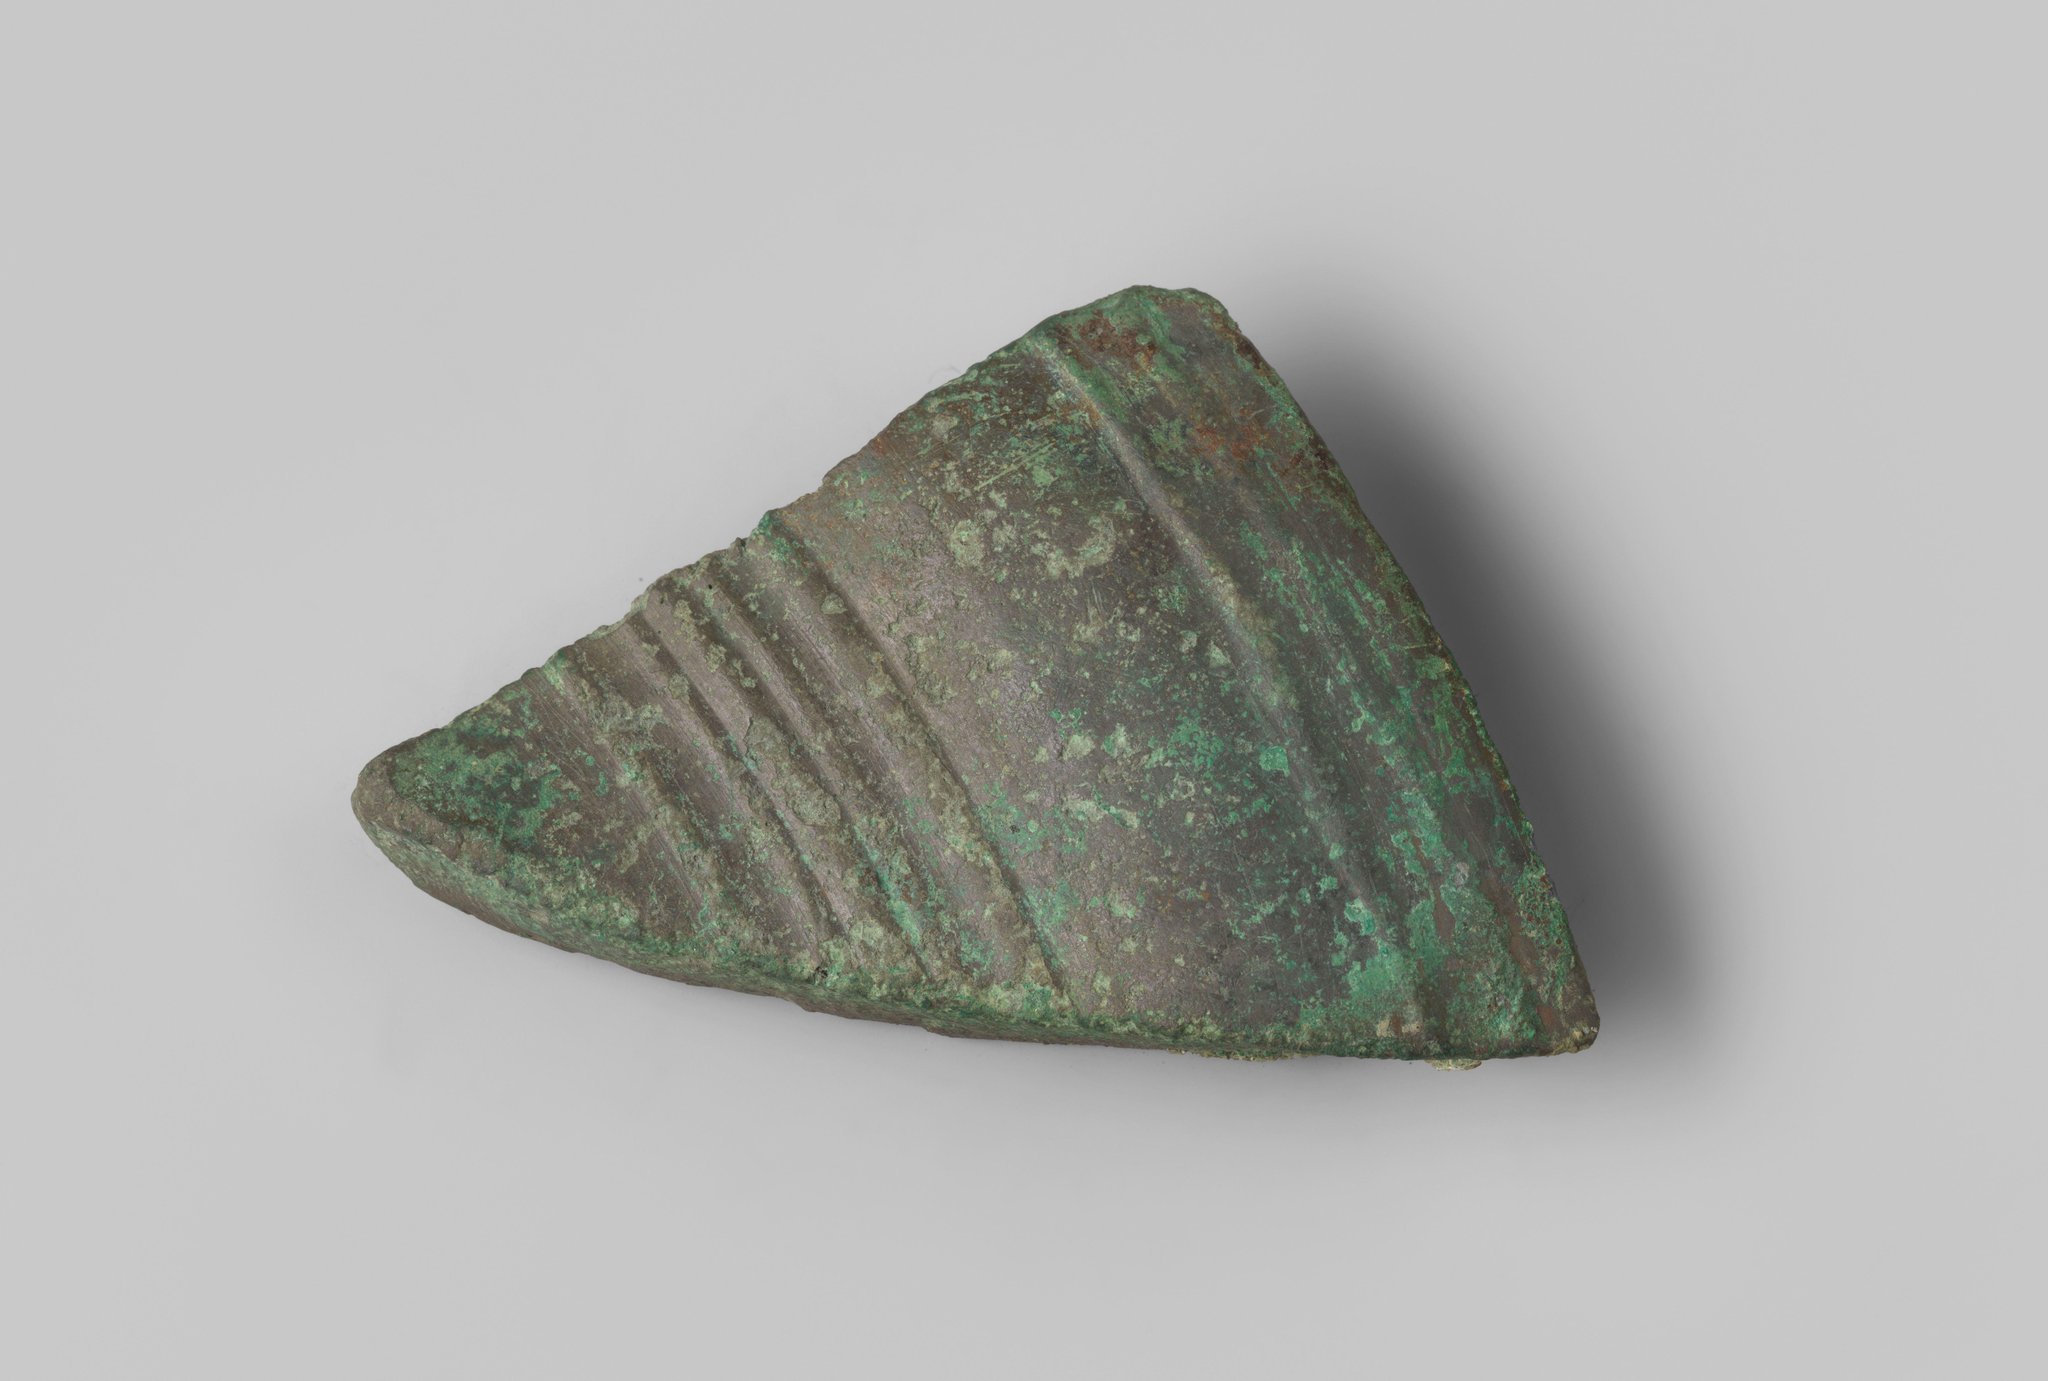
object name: ship bell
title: Fragment scheepsbel uit het wrak van de Oost-Indiëvaarder Hollandia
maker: Anonymous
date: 1700-1743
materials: copper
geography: netherlands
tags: verenigde oostindische compagnie, hollandia (schip), annet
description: Acoustic, bell (ship's); fragment of rim, concentric band moulding, fits to NG 1980-27H2665/2979.